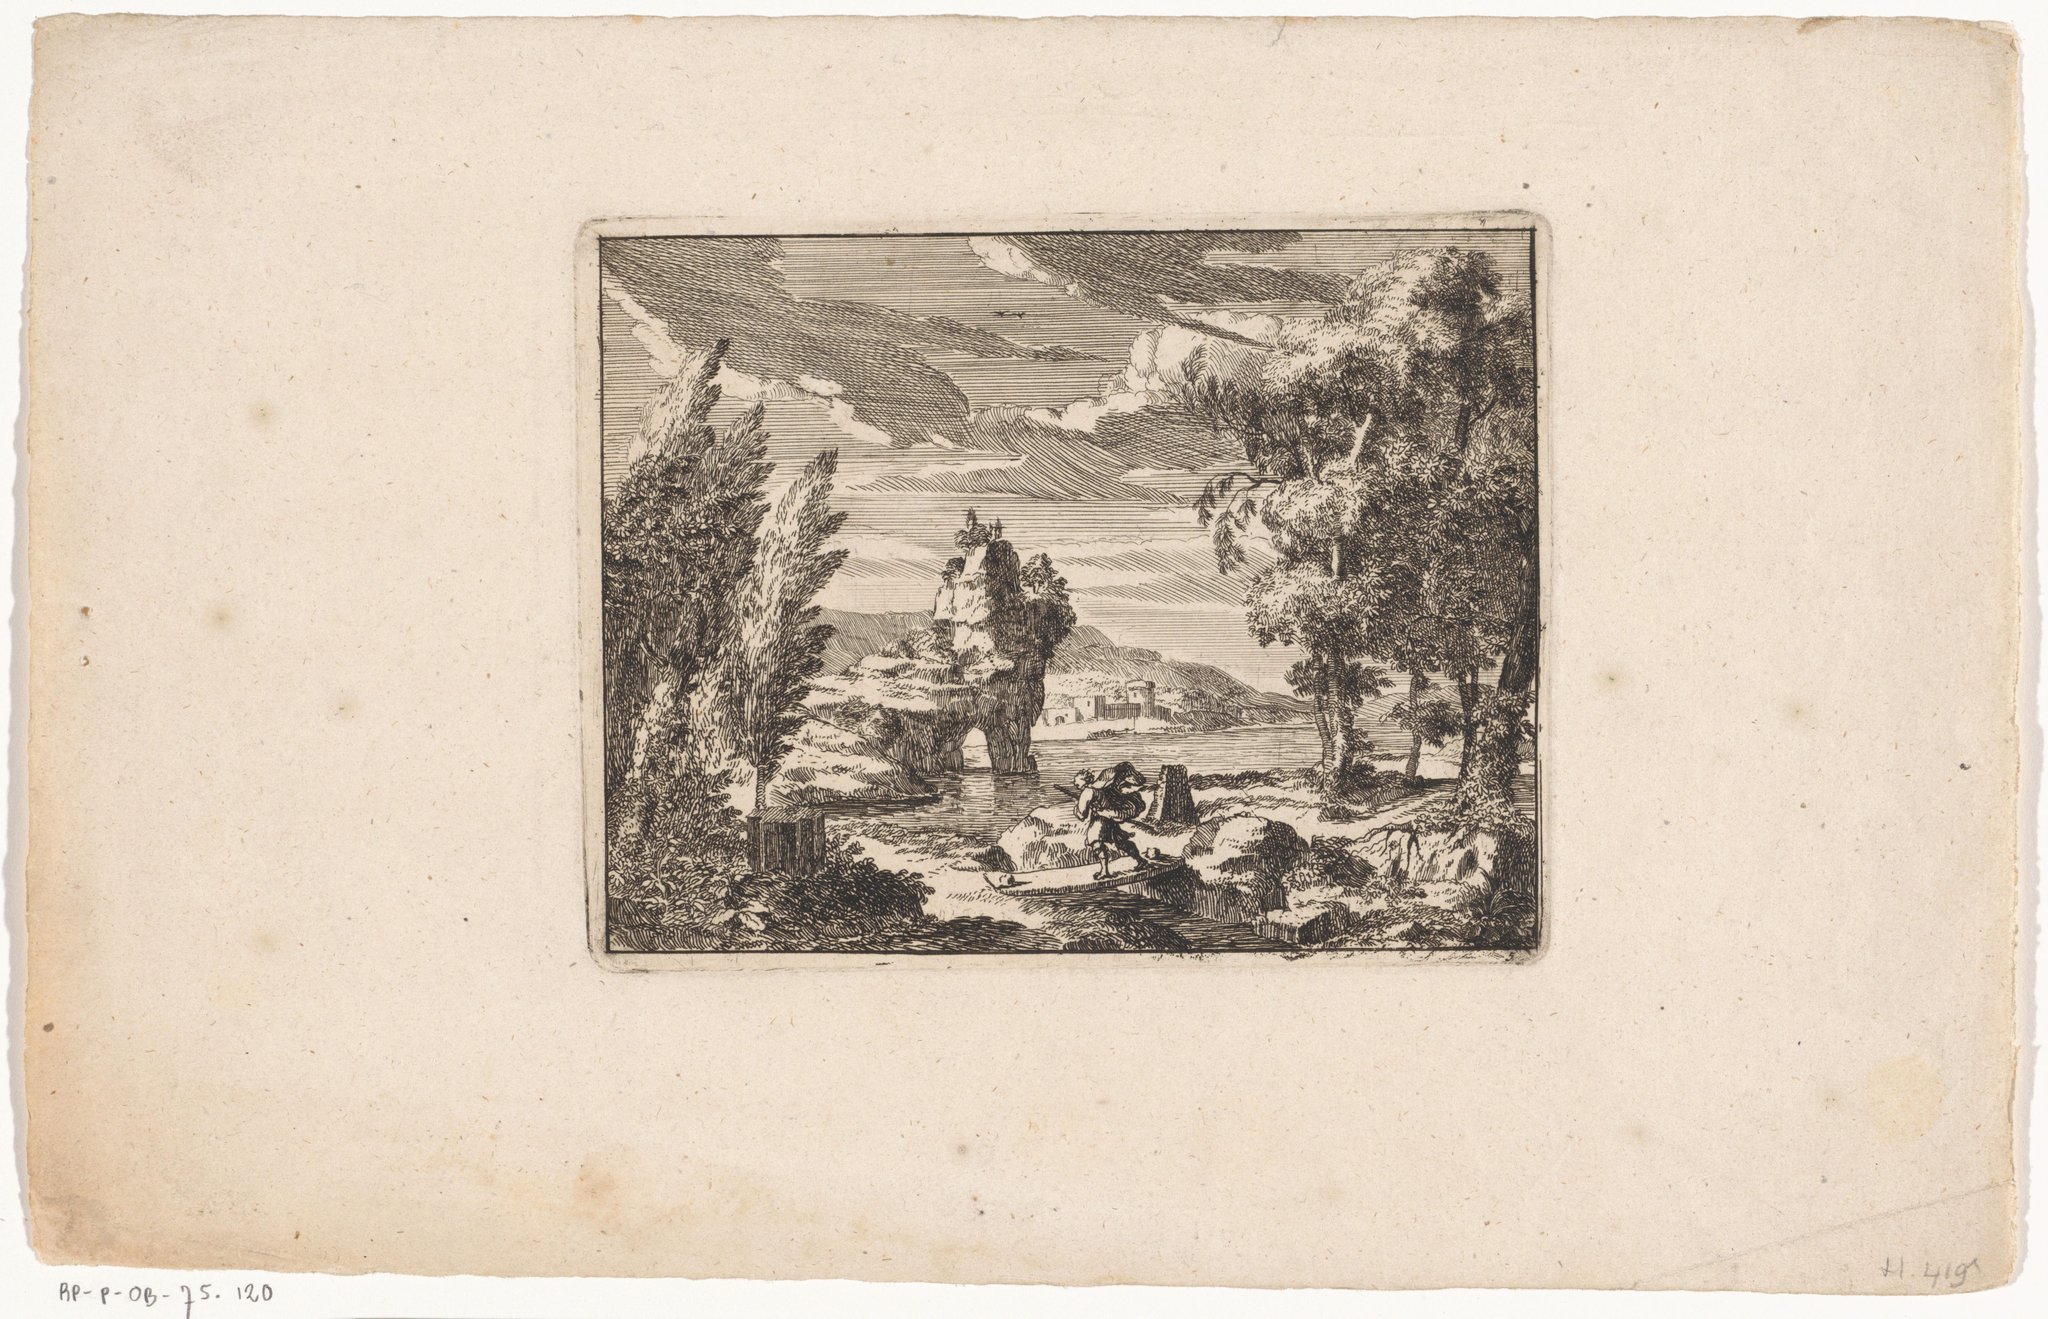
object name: print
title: Rivierlandschap met reiziger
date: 1701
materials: paper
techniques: etching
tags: improvised bridge, temporary bridge ~ military engineering, river, 'en route', traveller under way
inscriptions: collector's mark: Lugt 2228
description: Een man wandelt over een geïmproviseerde brug in een rivierlandschap met rotsen.